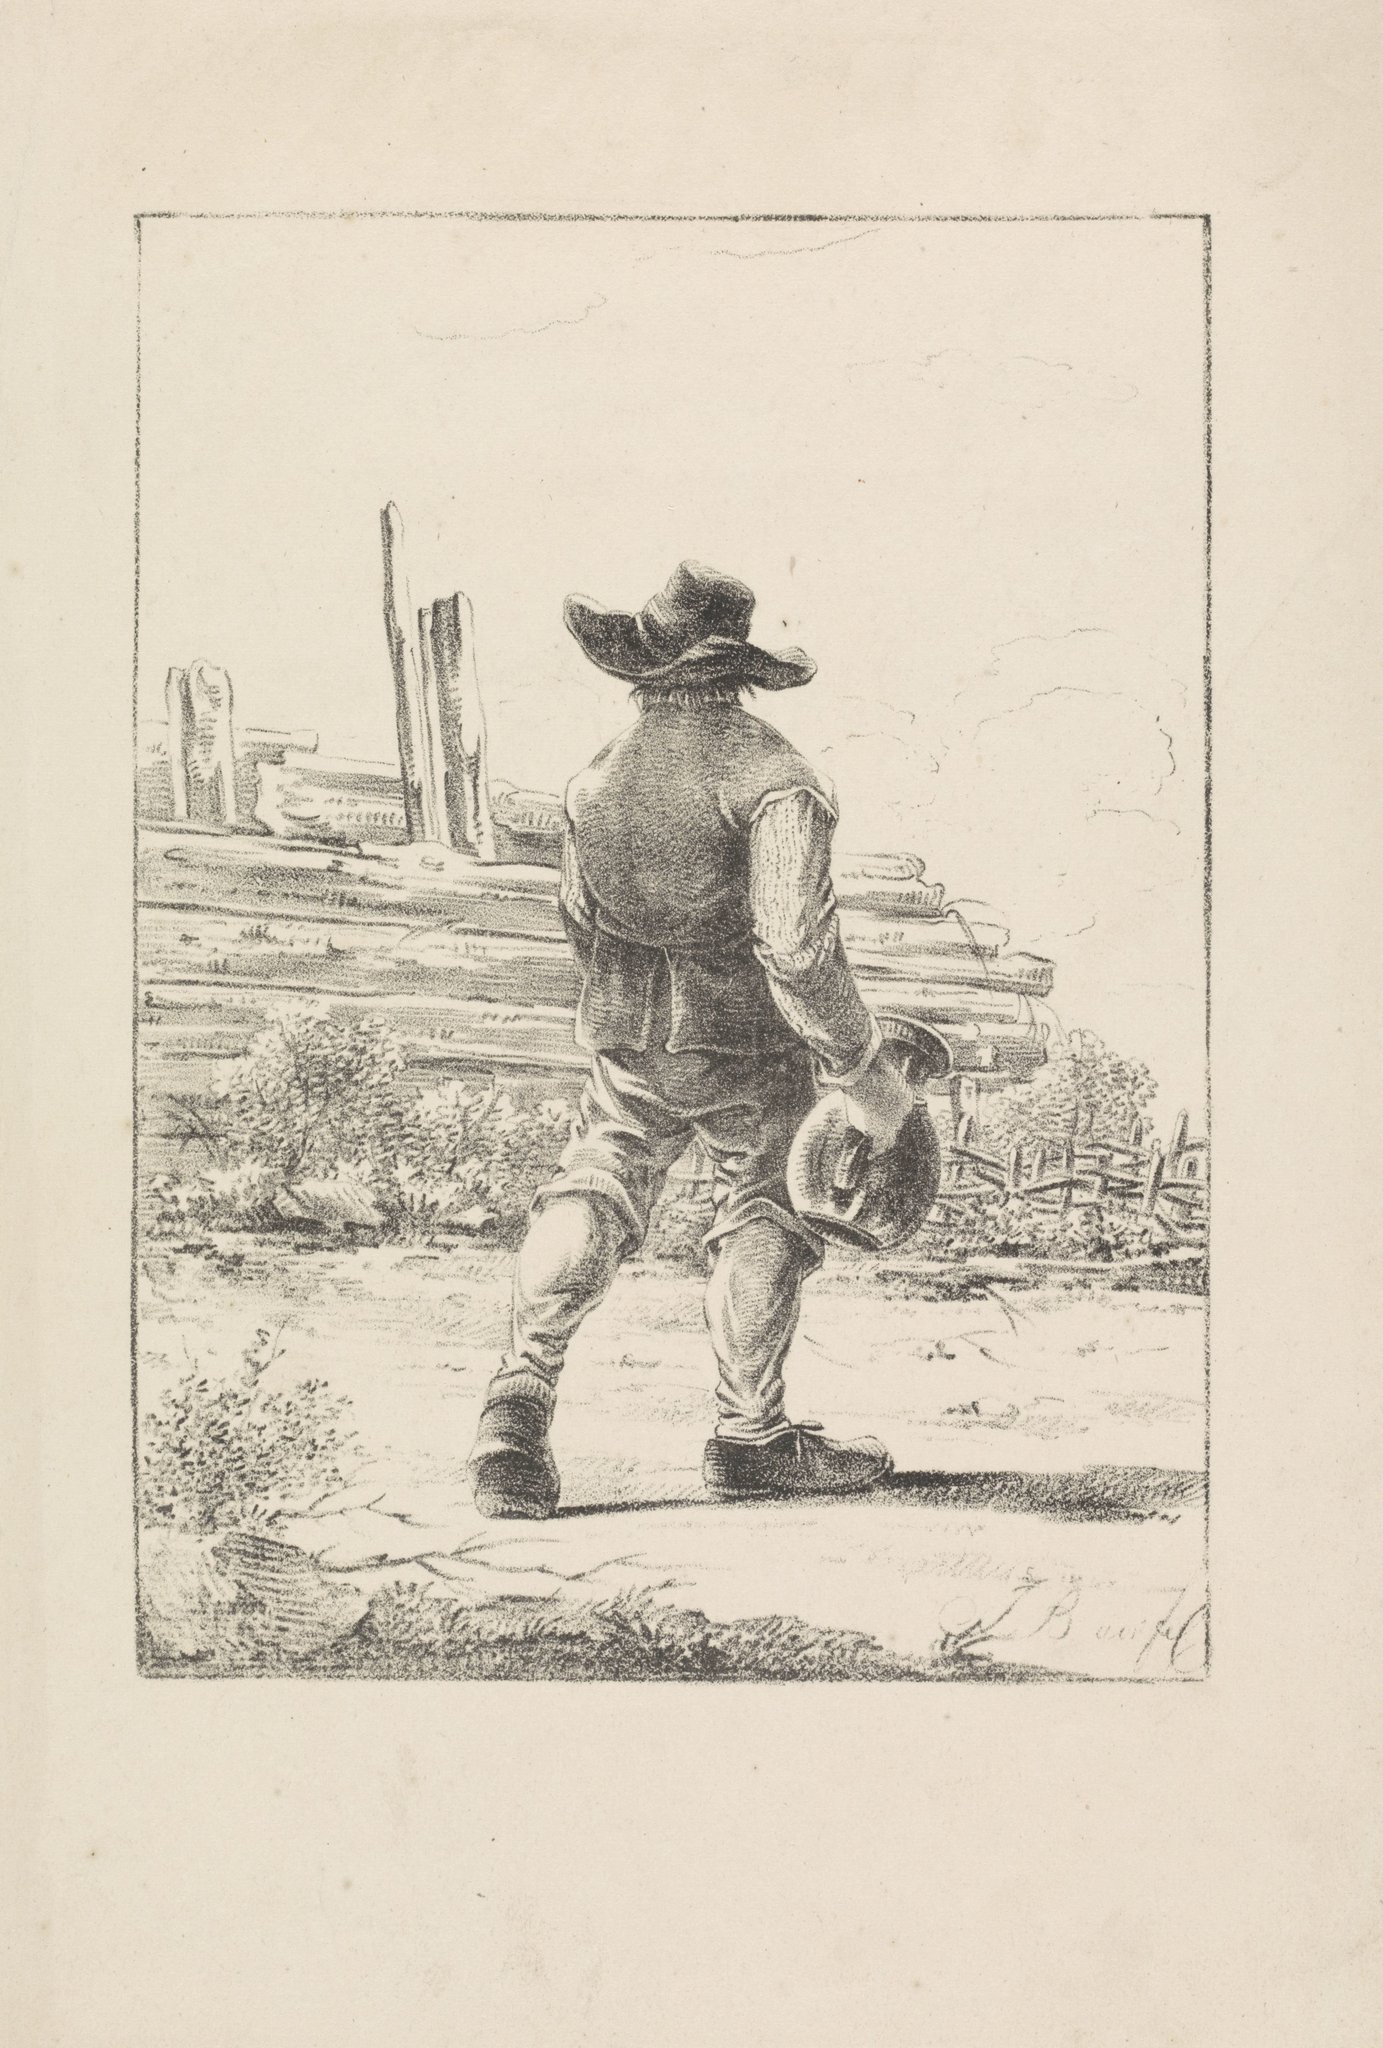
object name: print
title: Man met kruik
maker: joannes bemme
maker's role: print maker, printer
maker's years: 1775-1841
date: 1809-1841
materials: paper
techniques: lithograph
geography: netherlands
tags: walking (+ back view), jar, jug (used as drinking-vessel)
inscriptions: collector's mark: Lugt 2228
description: De figuur is op de rug gezien en loopt in de open lucht. Hij draagt een hoed met een slappe brede rand en heeft een kruik in zijn rechterhand. Achter hem liggen houten planken.